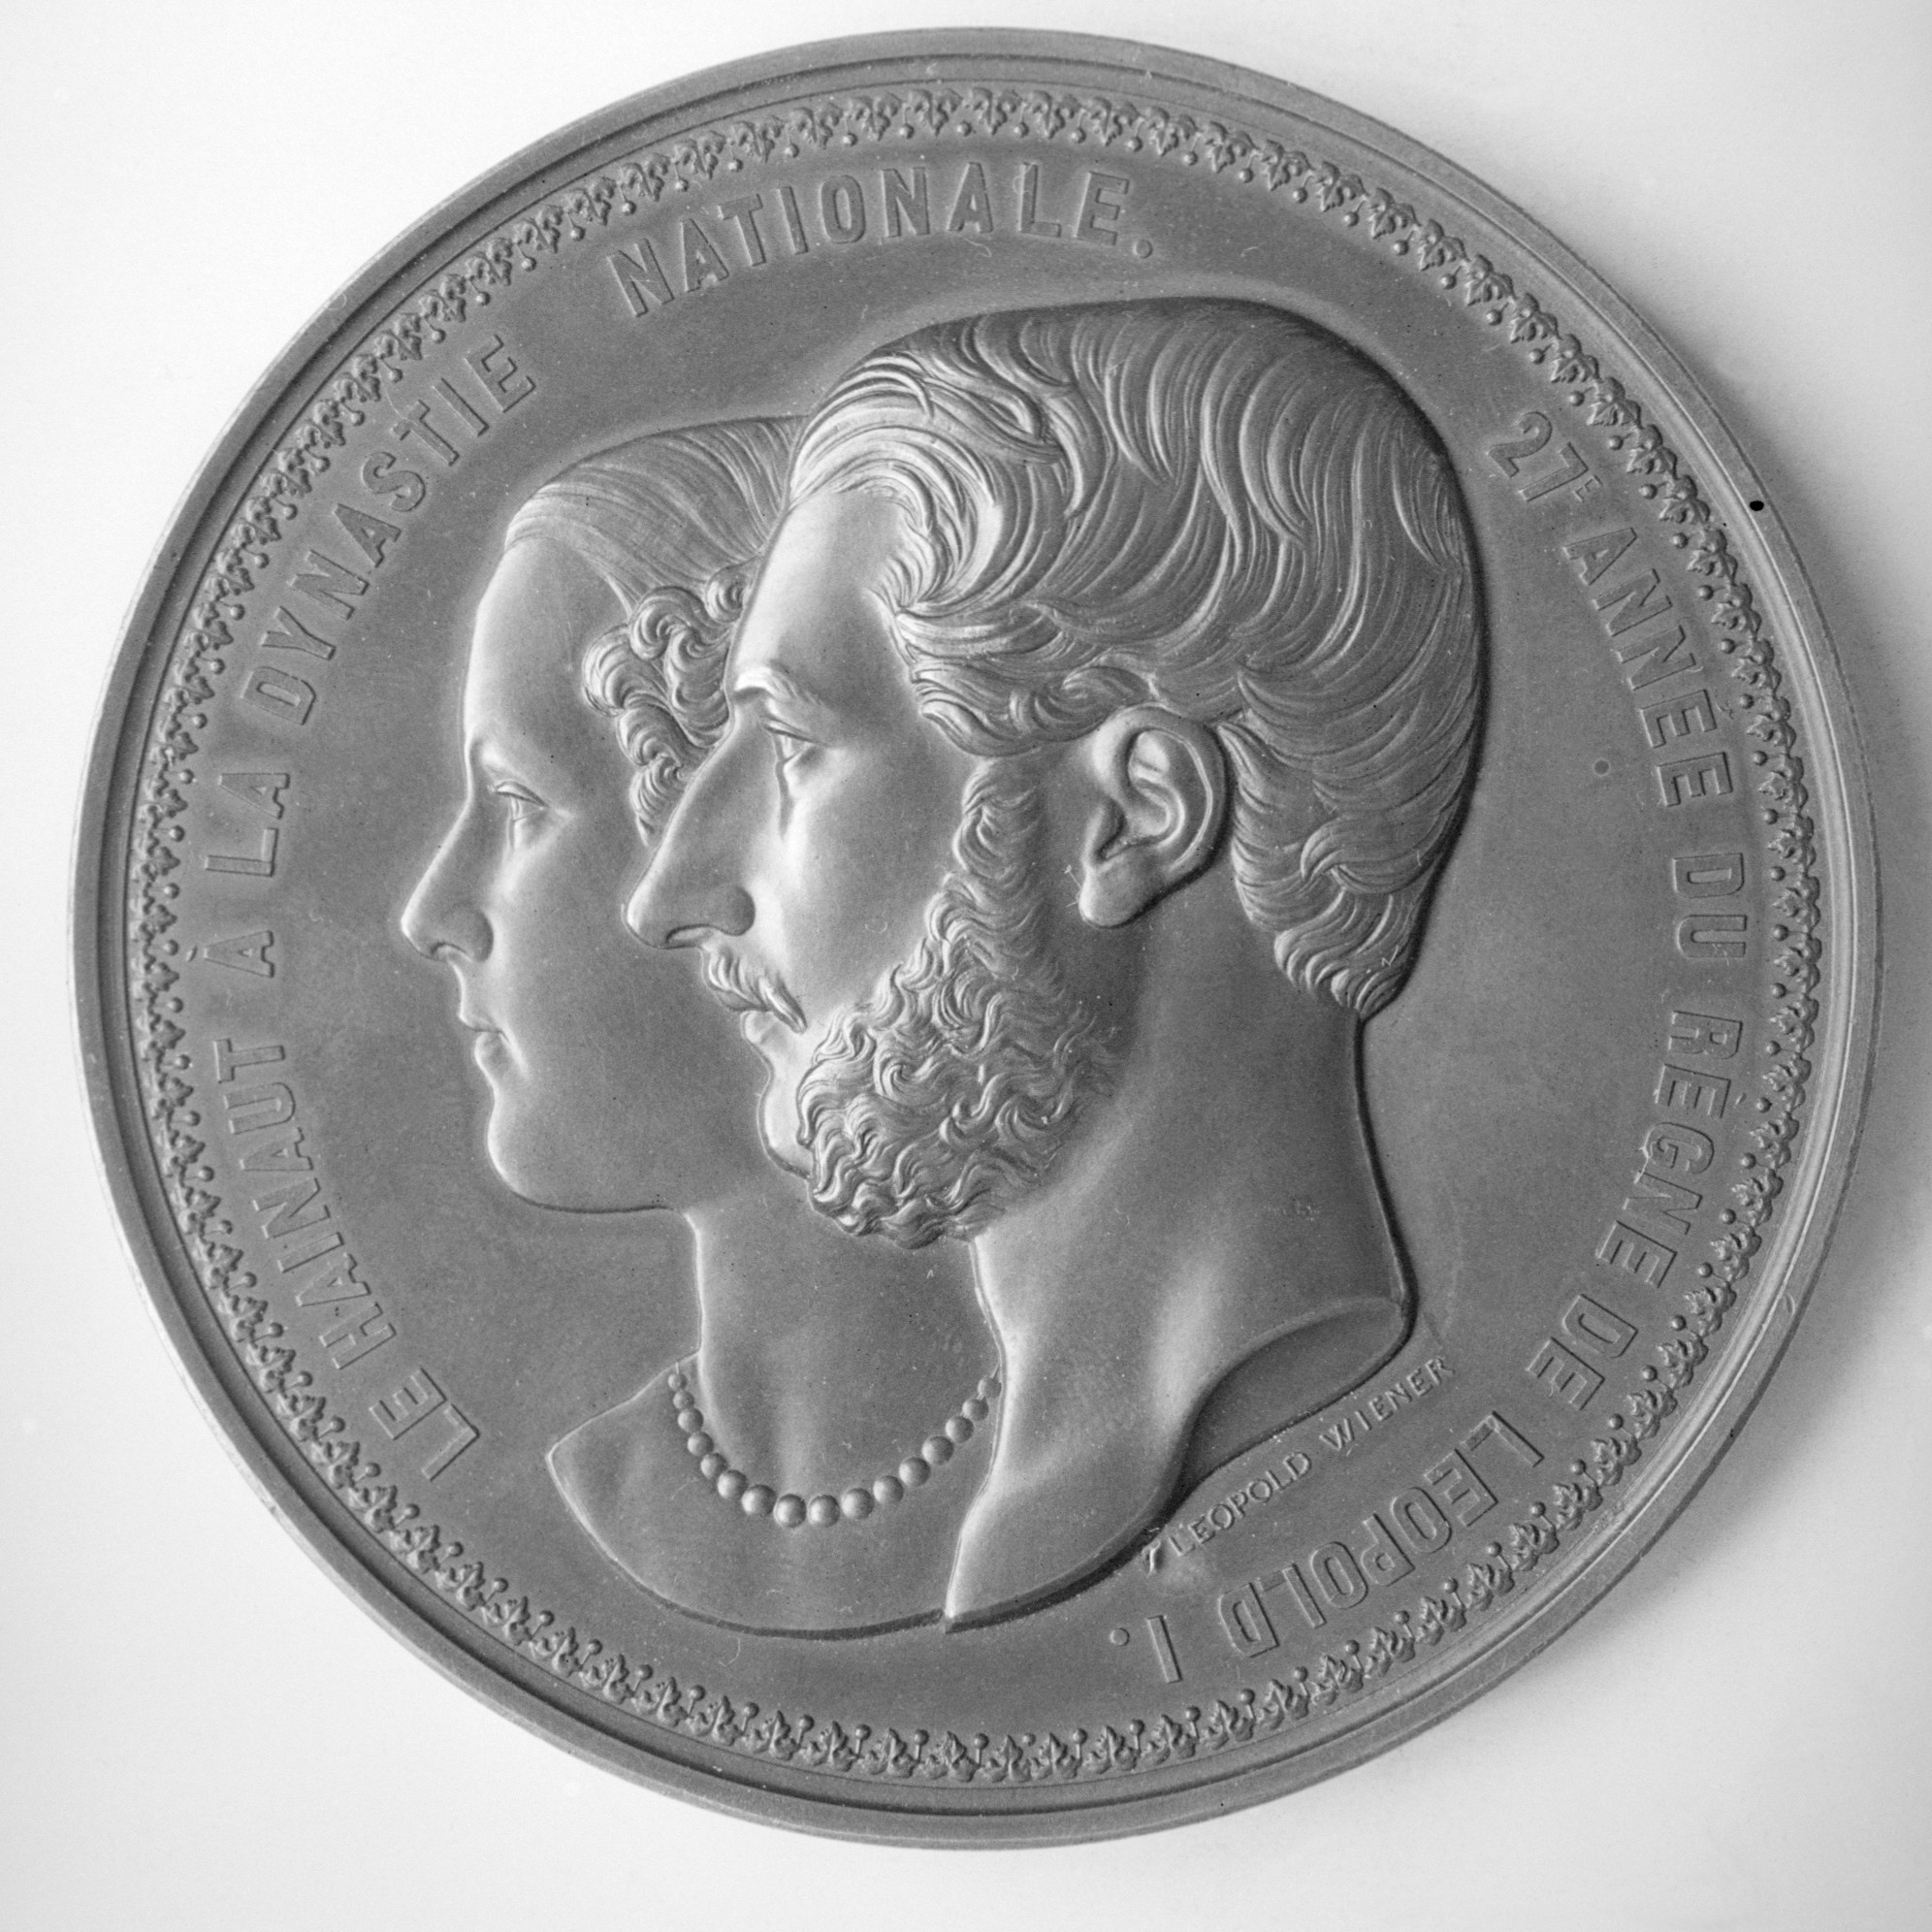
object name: medal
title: Birth of Comte de Hainault (1859–69)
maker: leopold wiener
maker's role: artist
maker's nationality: belgian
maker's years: 1823-1891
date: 1854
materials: bronze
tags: men,profiles,women